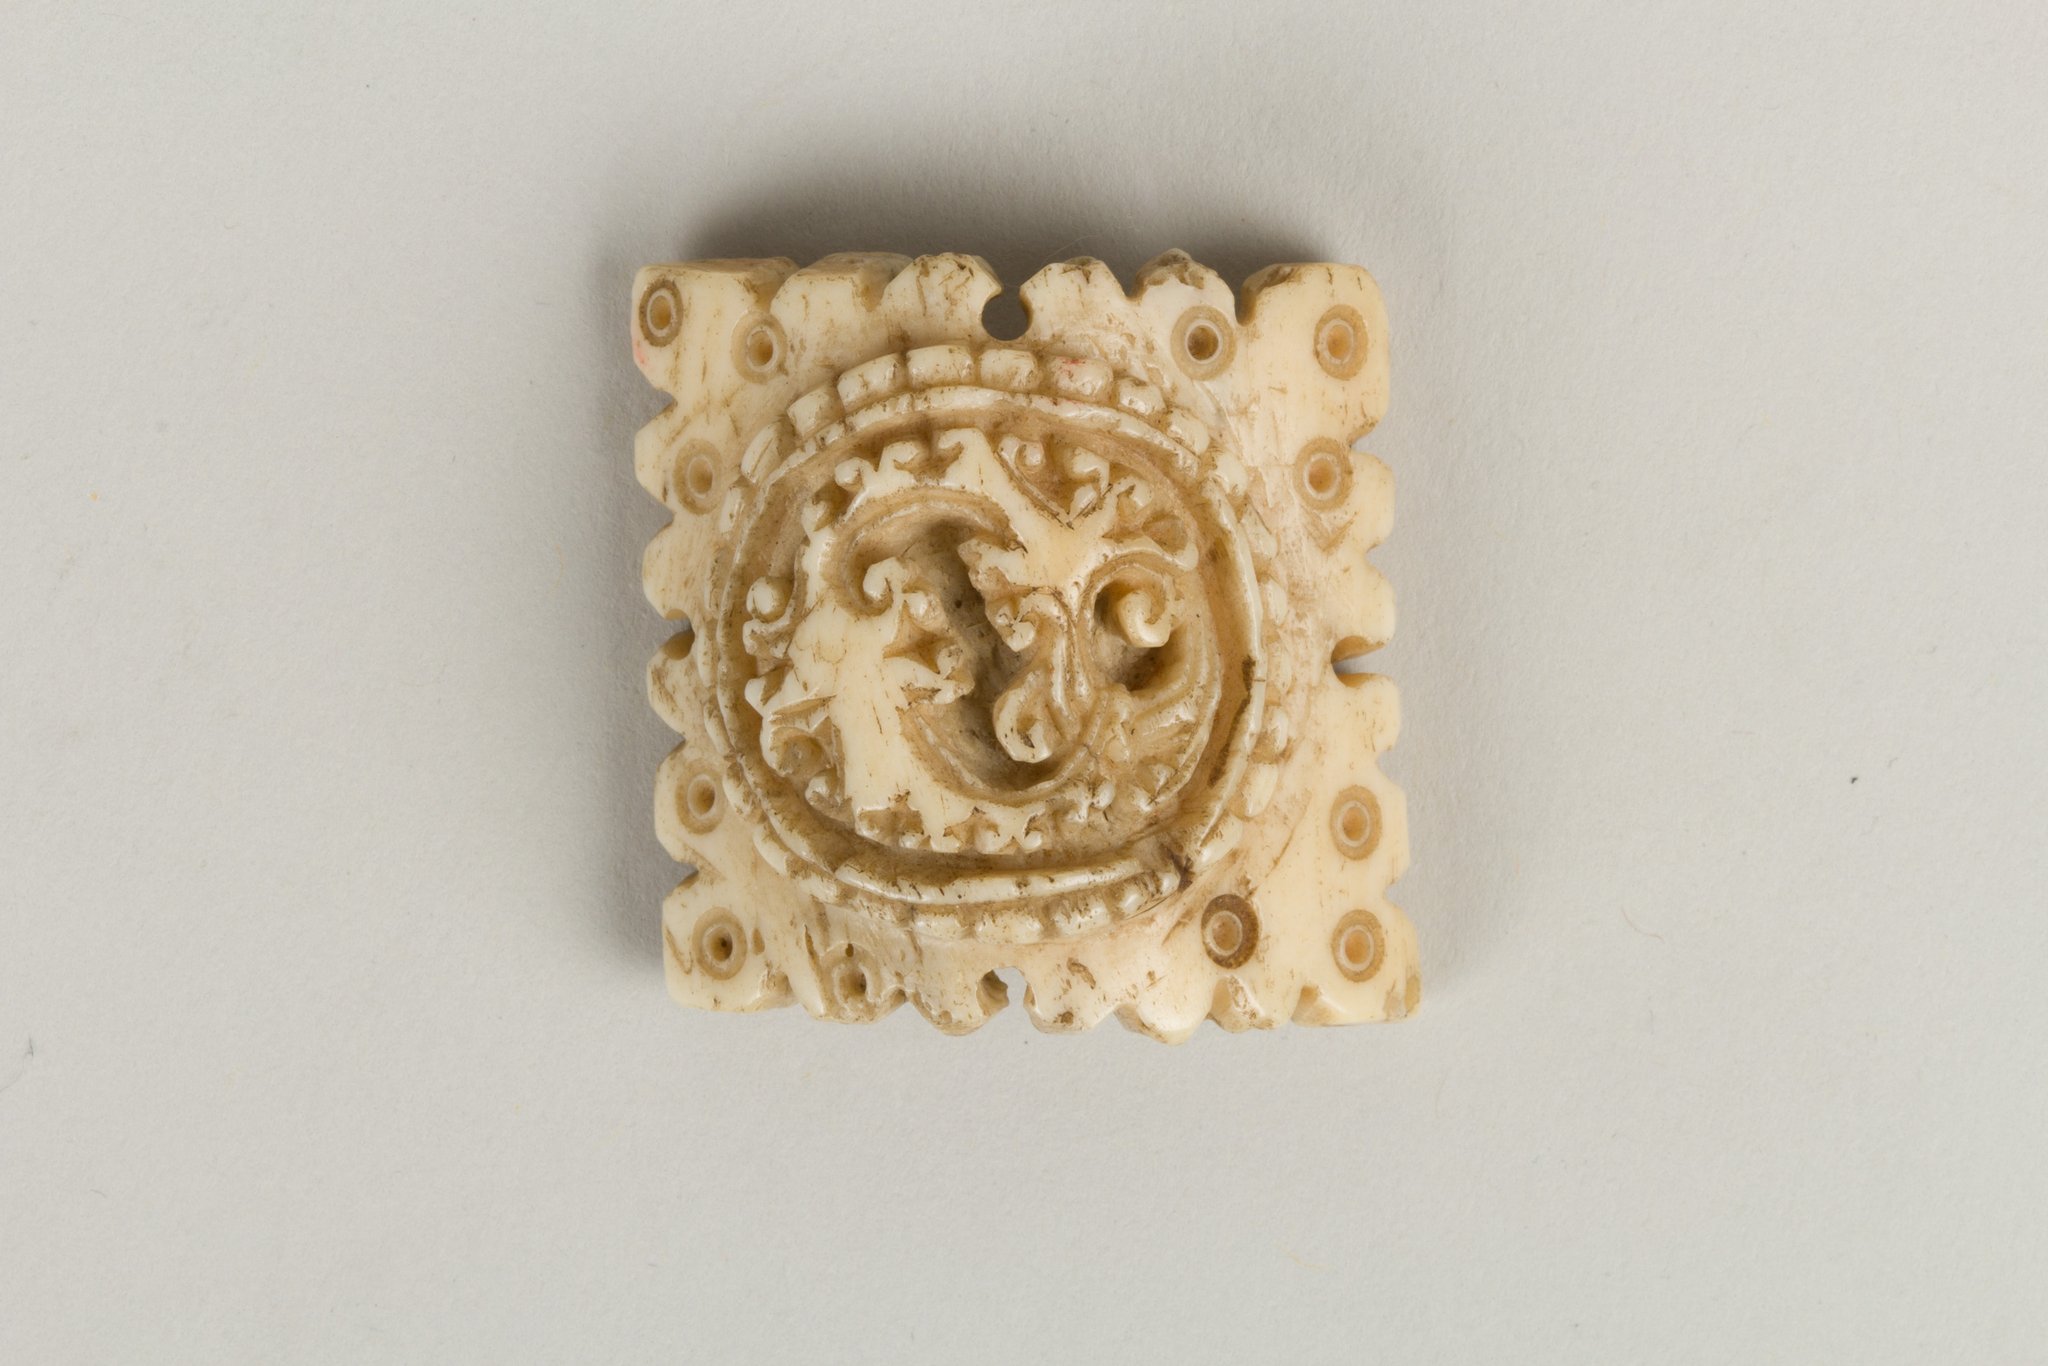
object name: figure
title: Element from a Tantric Ritual Apron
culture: tibetan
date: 1701-1800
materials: bone